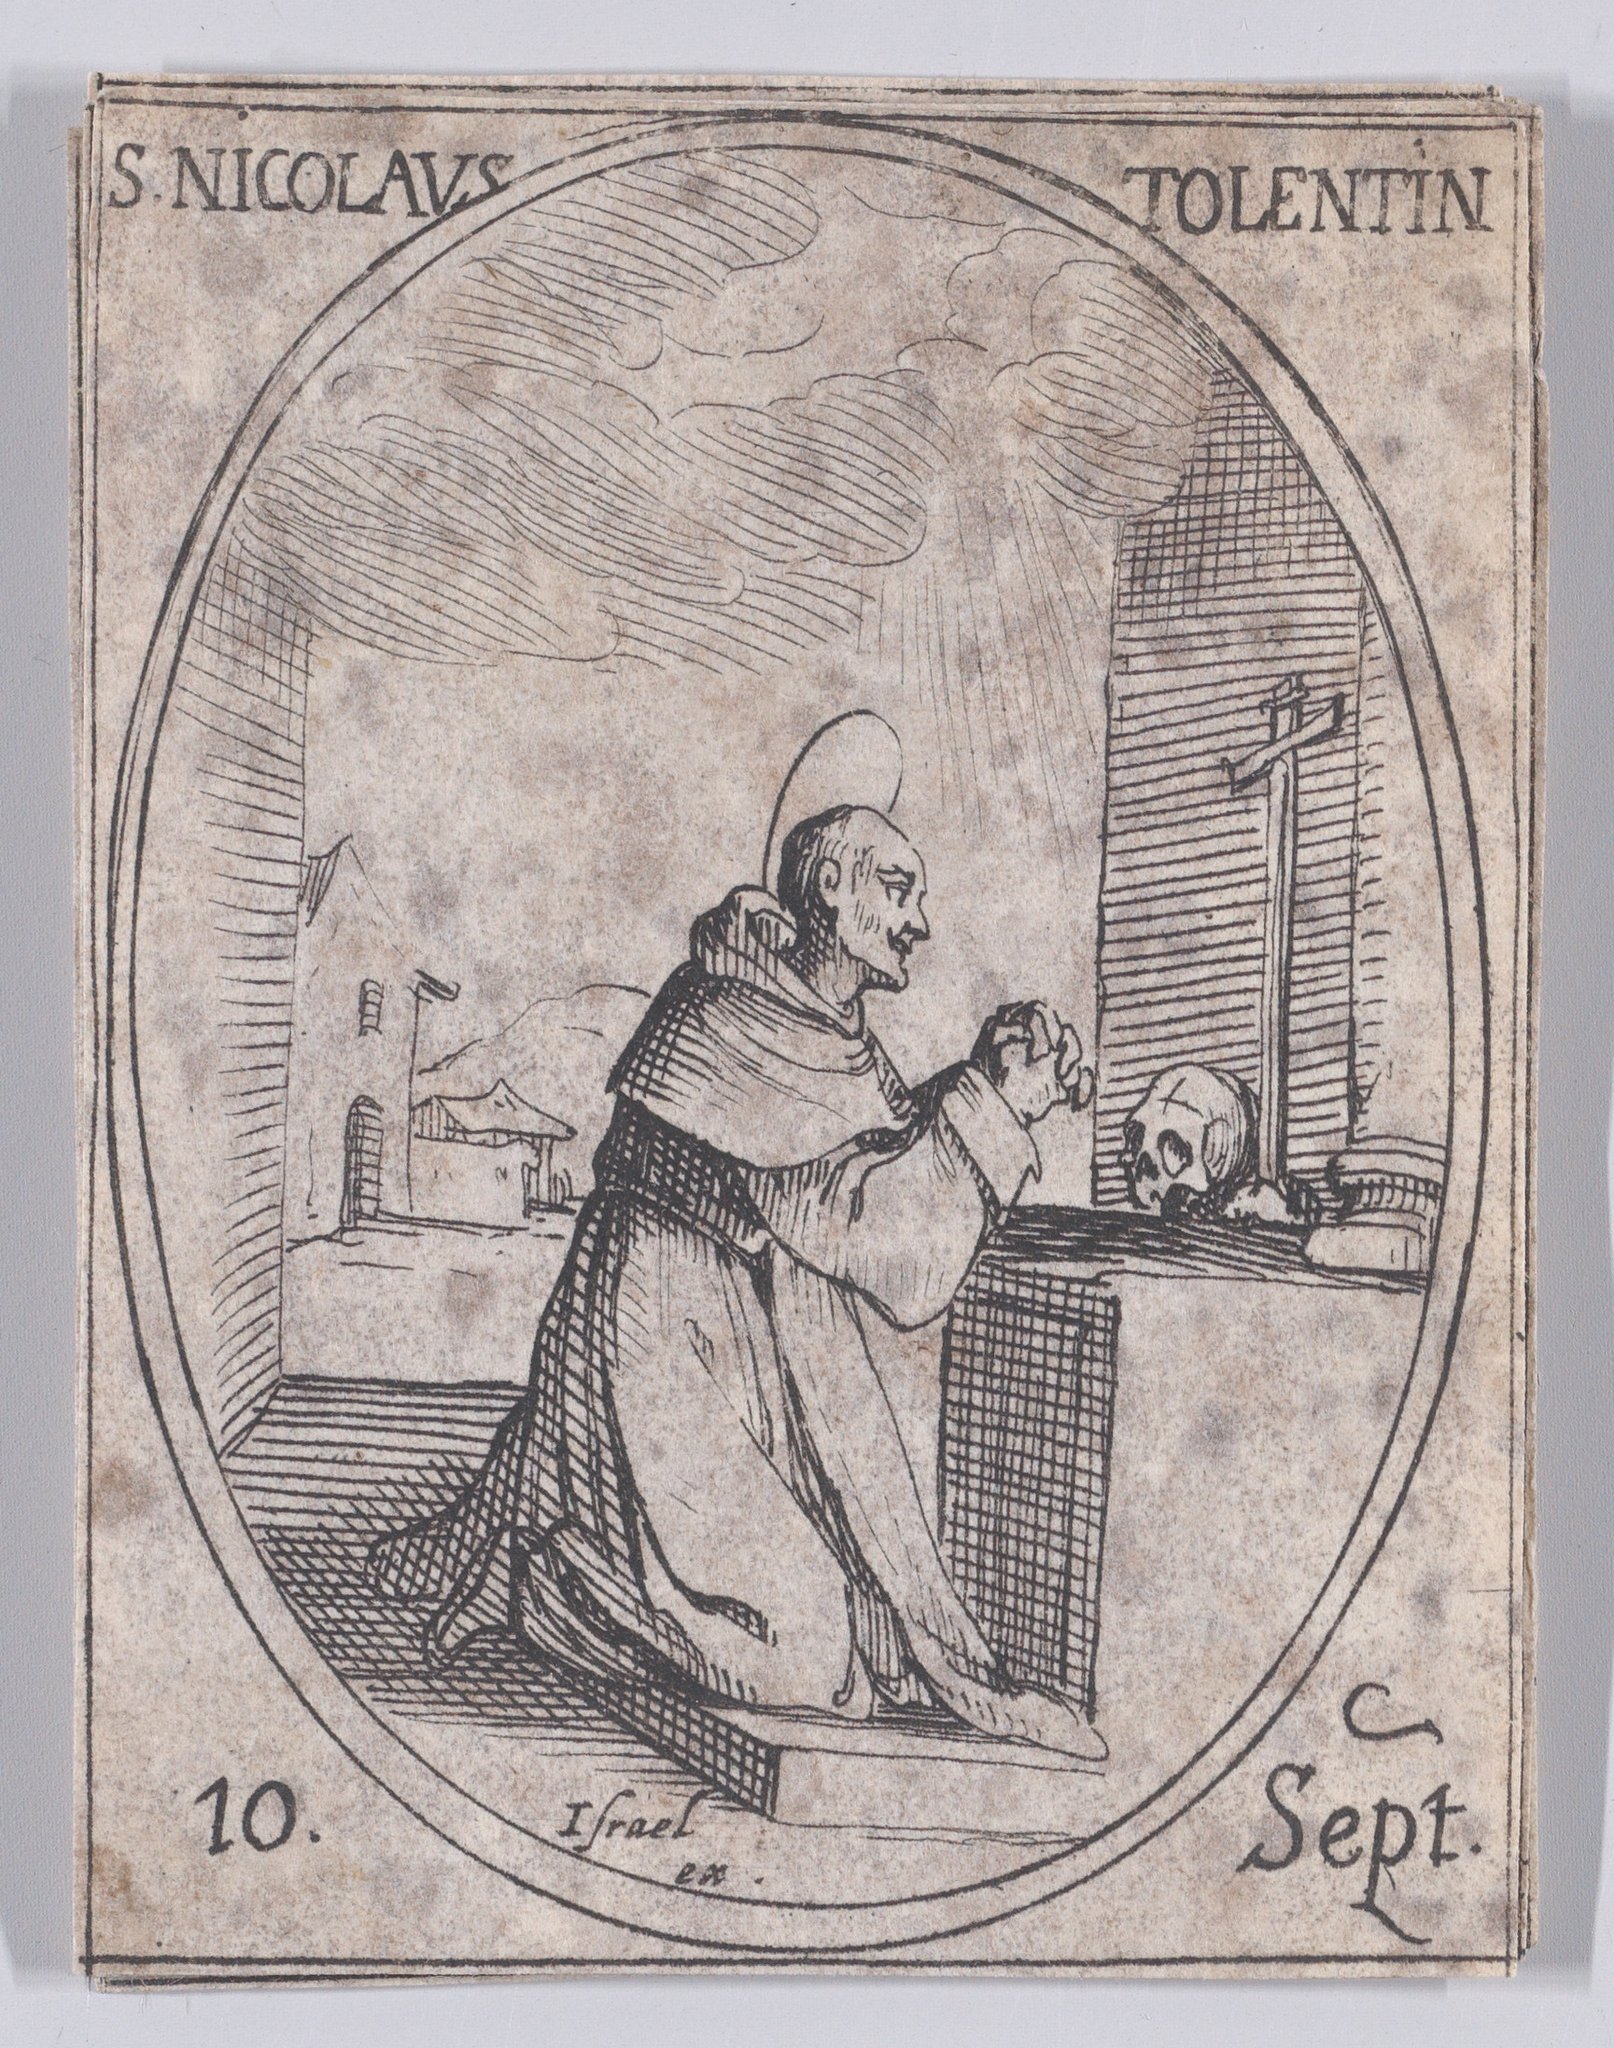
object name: print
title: S. Nicolas de Tolentino (St. Nicholas of Tolentino), September 10th, from "Les Images De Tous Les Saincts et Saintes de L'Année" (Images of All of the Saints and Religious Events of the Year)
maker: jacques callot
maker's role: artist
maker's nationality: french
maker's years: 1592-1635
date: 1636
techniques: etching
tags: altars,men,saints,praying